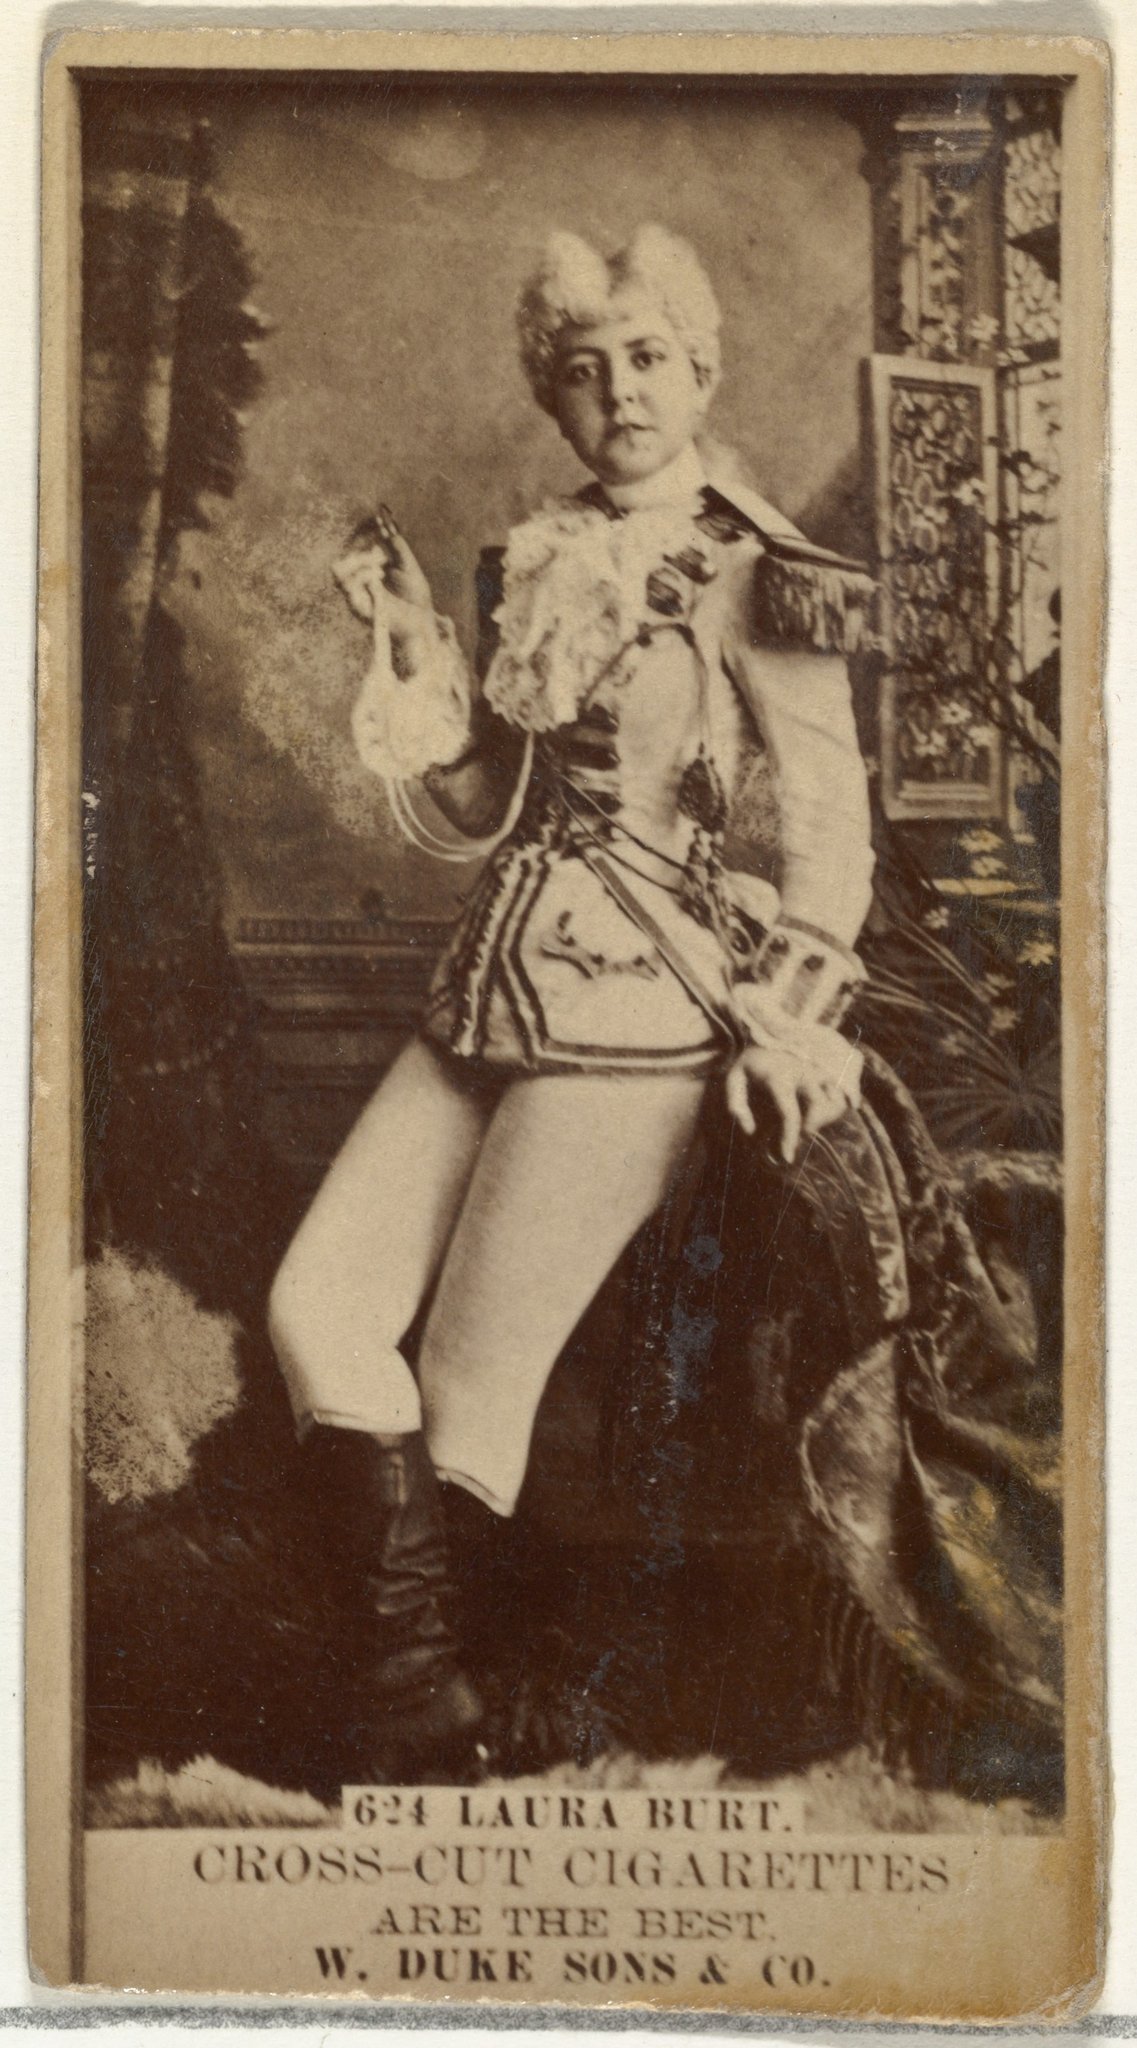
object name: photograph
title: Card Number 624, Laura Burt, from the Actors and Actresses series (N145-3) issued by Duke Sons & Co. to promote Cross Cut Cigarettes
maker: w. duke, sons & co.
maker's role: publisher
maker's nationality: american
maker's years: 1870-1920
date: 1880-1889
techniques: albumen silver print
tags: portraits,women,actresses